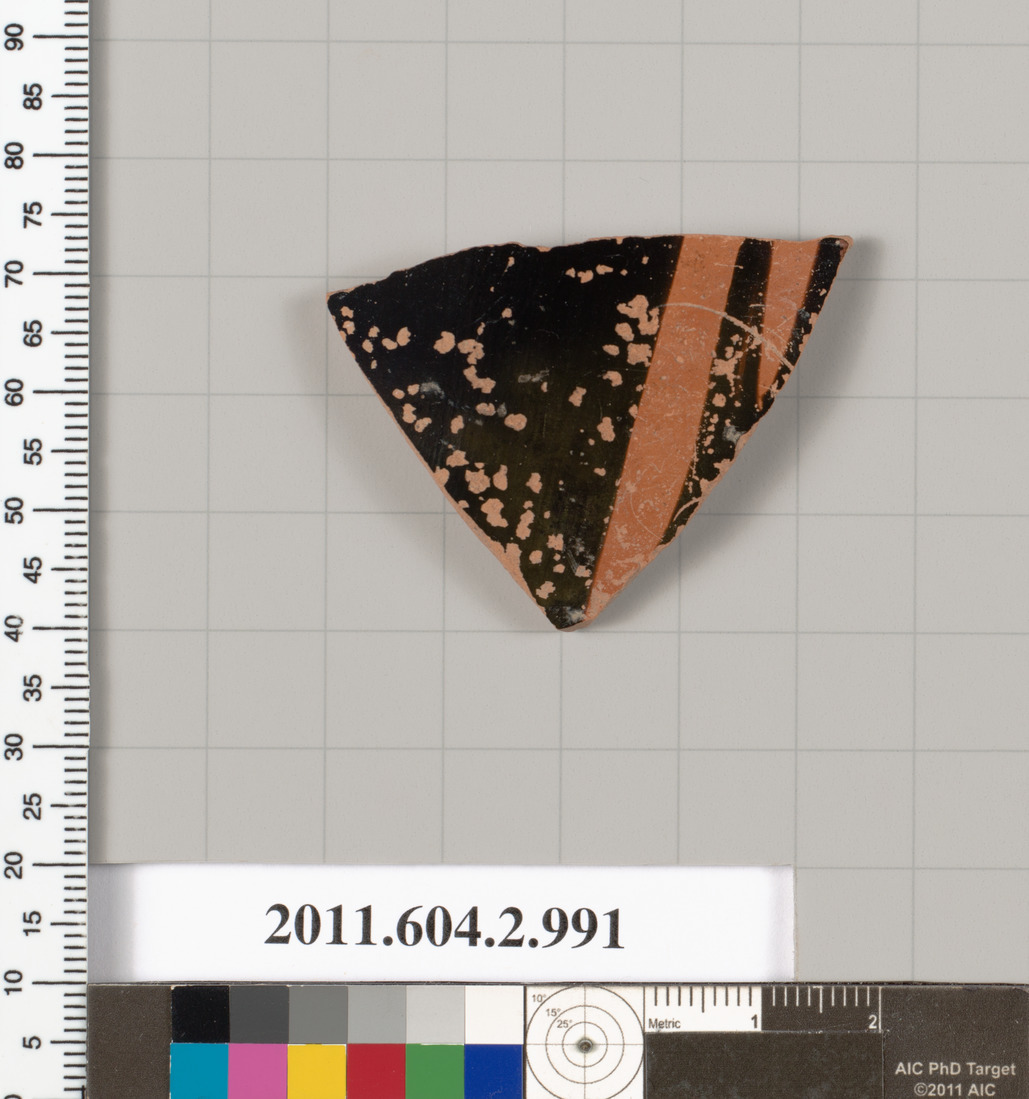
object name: oinochoe fragment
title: Terracotta fragment of an oinochoe (jug)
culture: greek, attic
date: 467-435 BCE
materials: terracotta